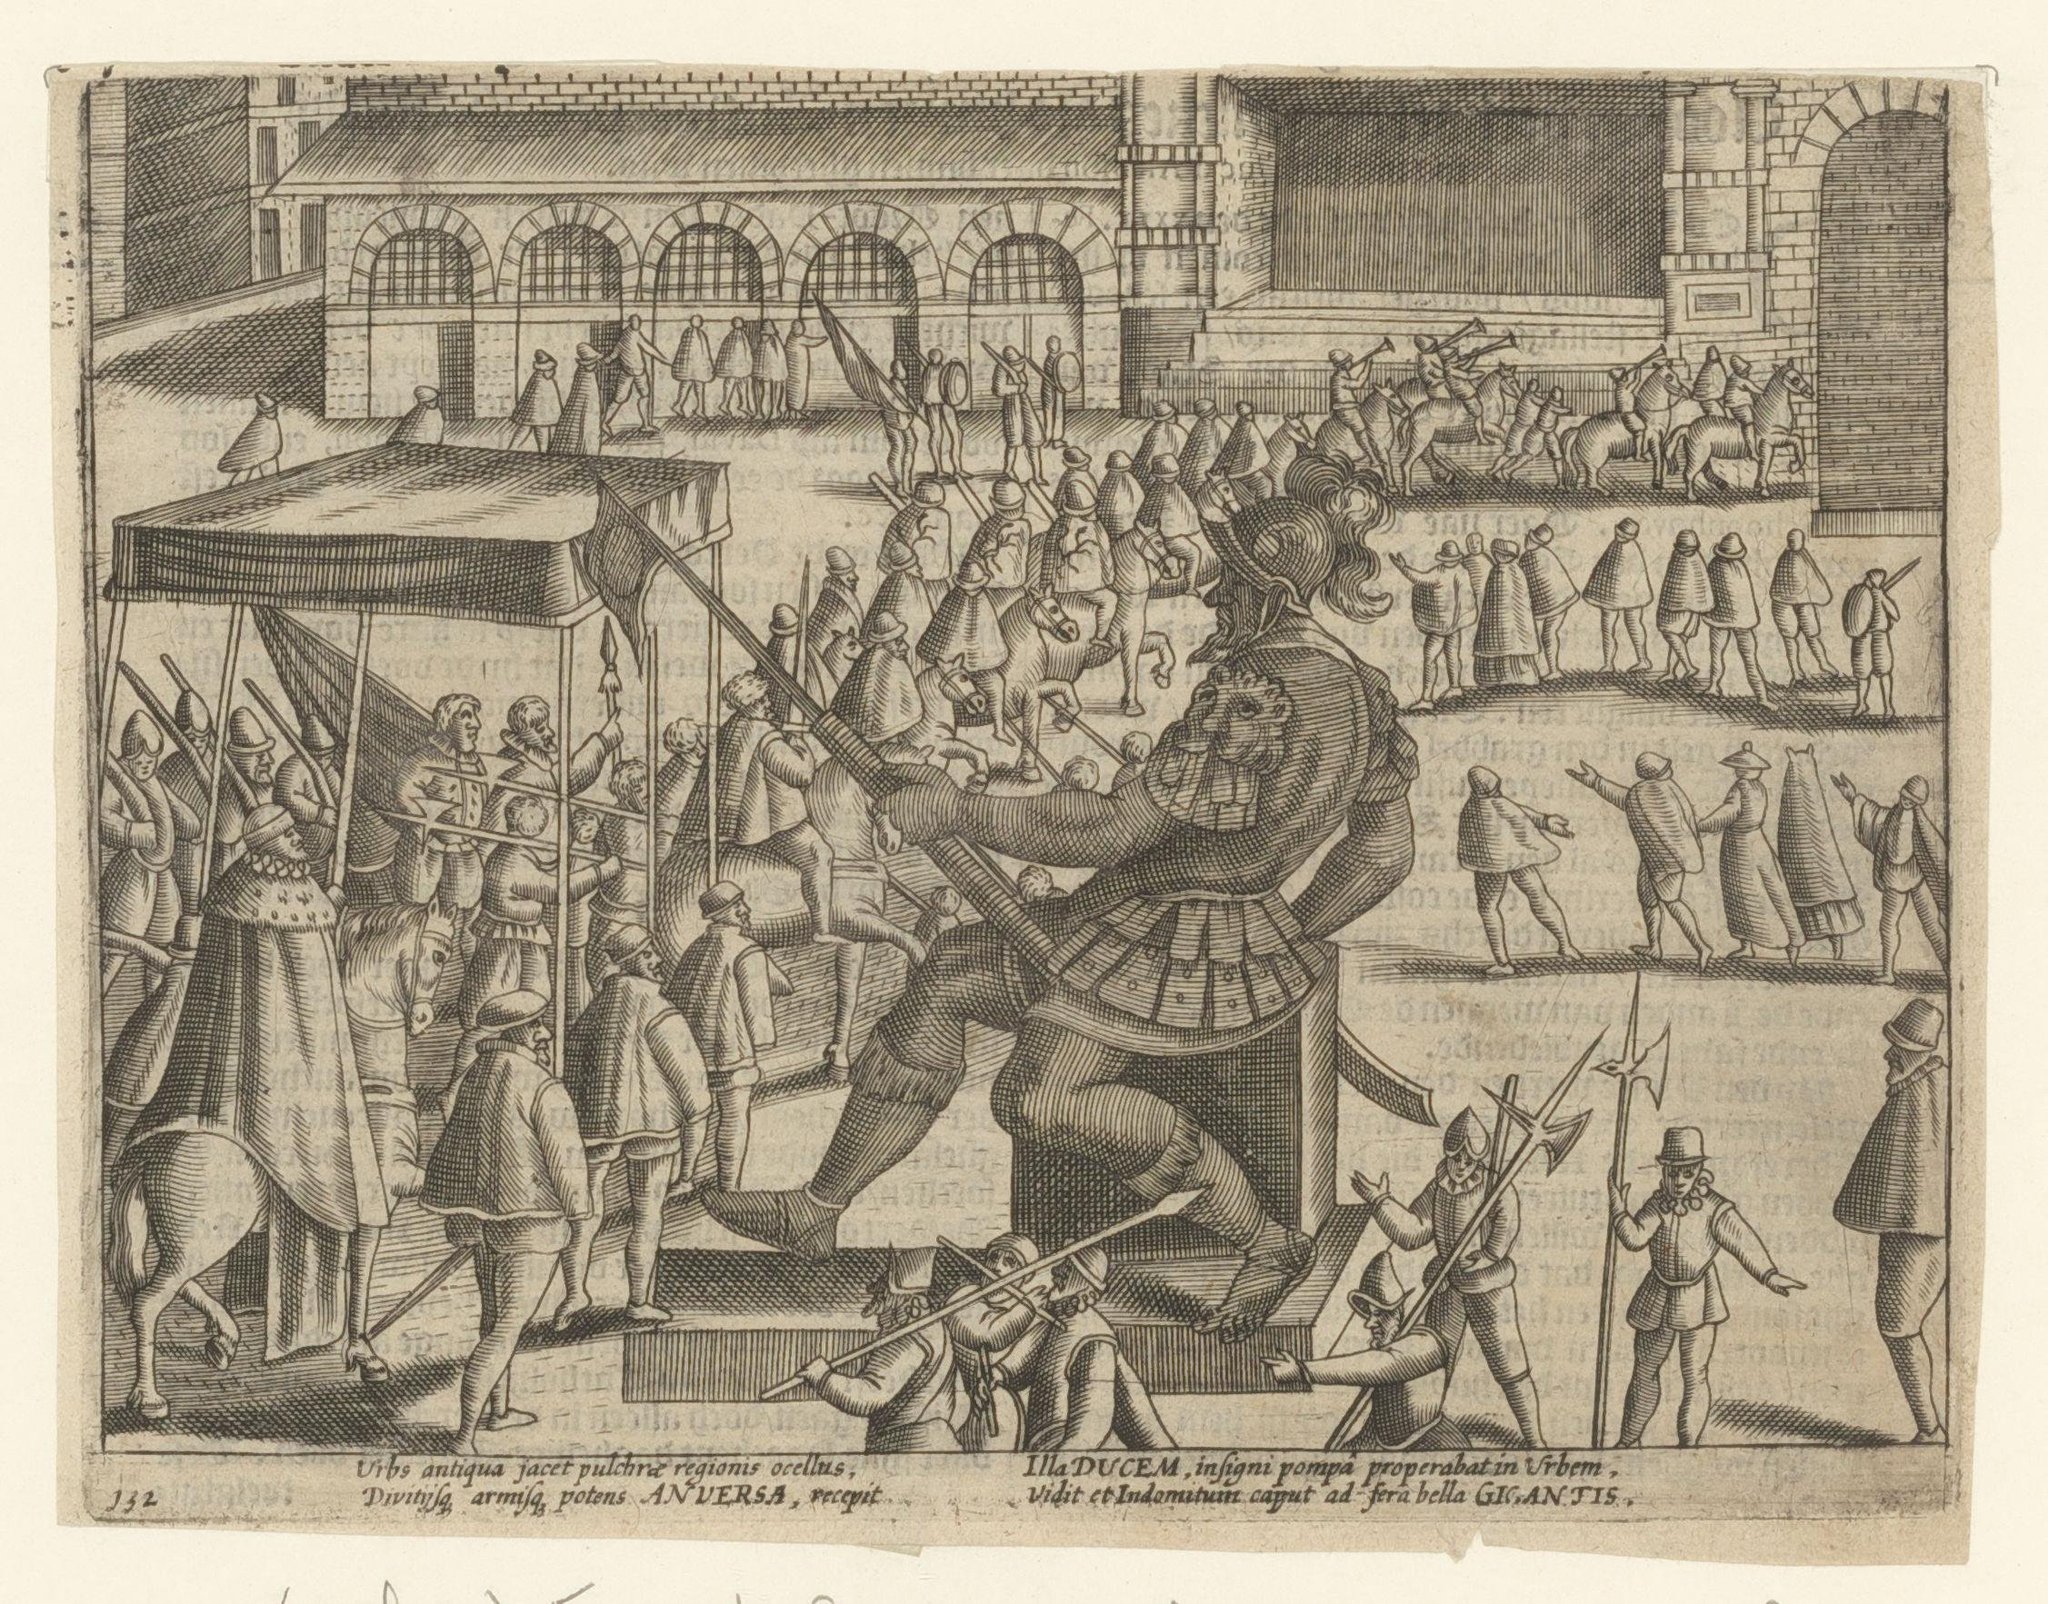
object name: book illustration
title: Intocht van de hertog van Anjou te Antwerpen; de stoet trekt langs het beeld van de reus Antigoon op de Grote Markt, 1582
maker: Anonymous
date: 1613-1615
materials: paper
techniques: engraving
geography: northern netherlands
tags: paris, françois-hercule de valois (hertog van anjou), triumphal entry and public reception, pageant, 'entrée solennelle', 'joyeuse entrée', giants, colossi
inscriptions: collector's mark, collector's mark: Lugt 1641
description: De stoet trekt langs het beeld van de reus Antigoon op de Grote Markt, 1582. Onderdeel van de feestelijke intocht van de hertog van Anjou te Antwerpen op 19 februari 1582. Met onderschrift van 4 regels in het Latijn. Genummerd 132. Bedrukt op achterzijde met tekst in het Nederlands. Onderwerpsrubrieken binnen de Atlas Zeden en Gewoonten: Krijgswezen; prenten van Baudart. 80j. oorlog.